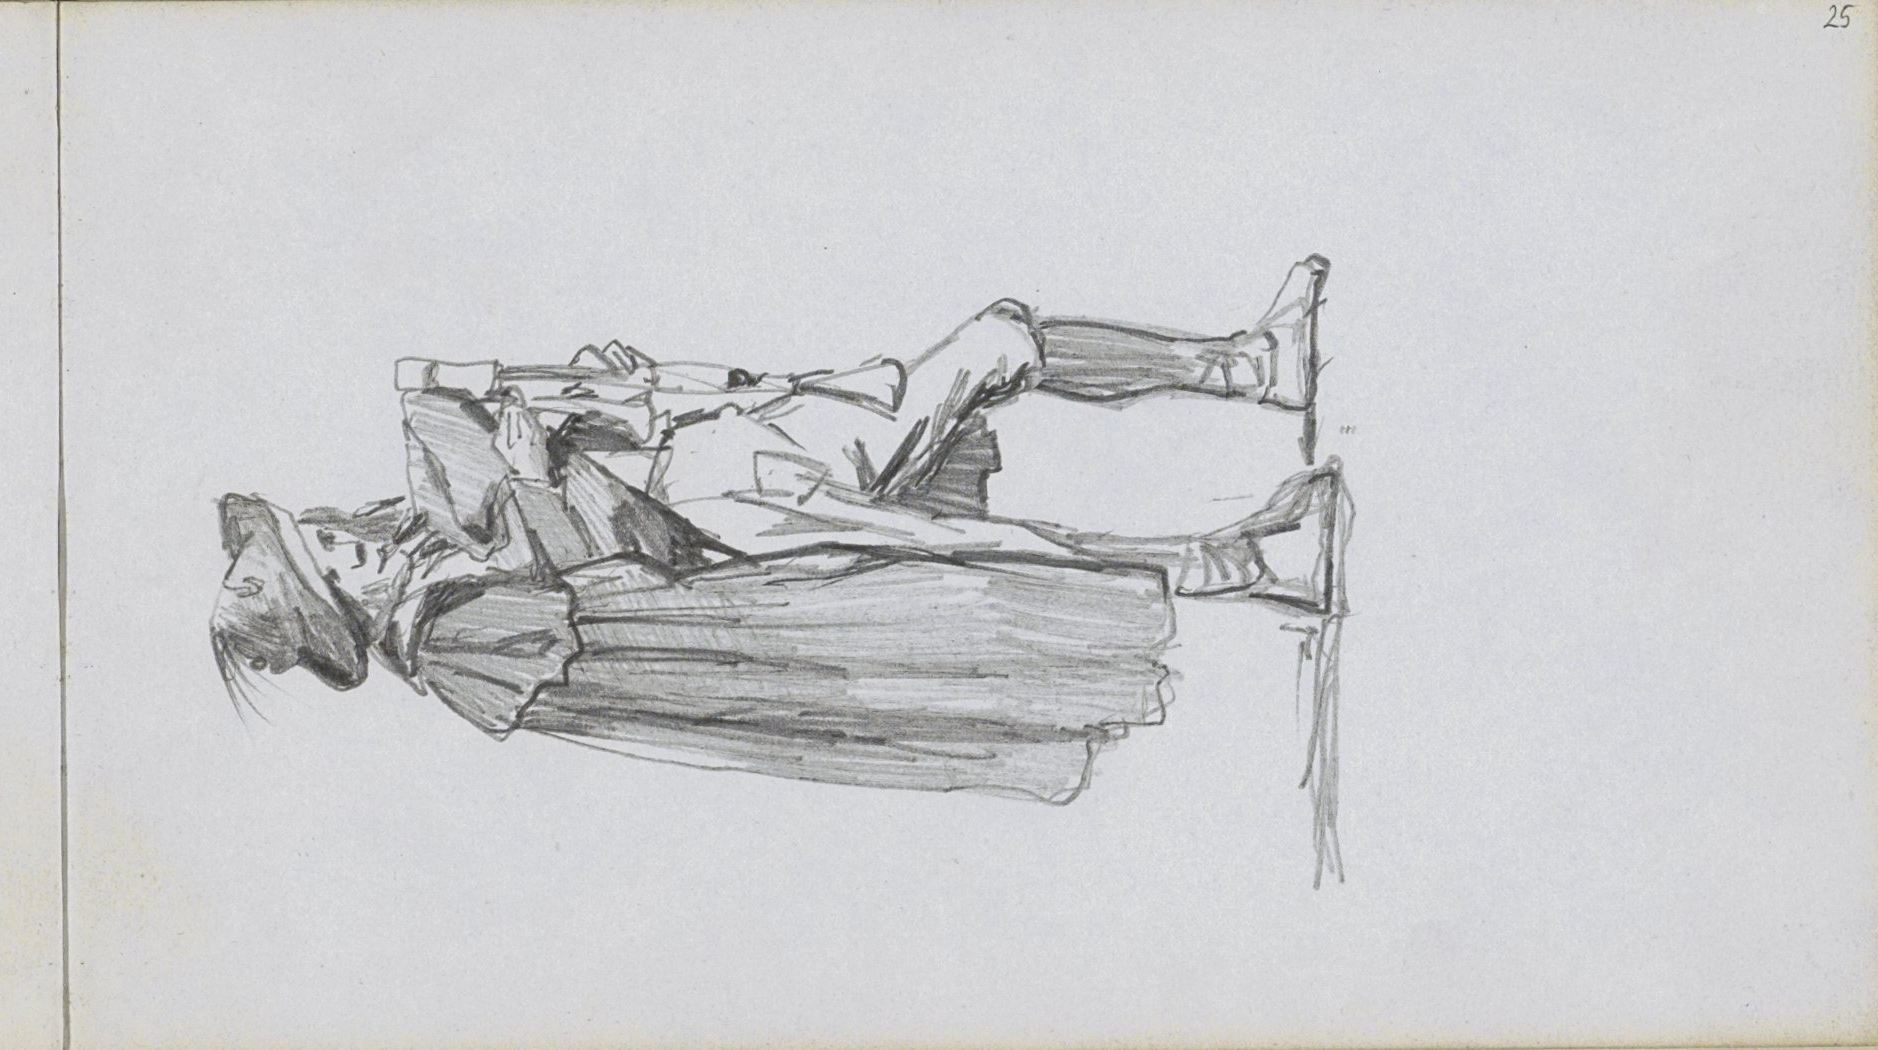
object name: sketchbook leaf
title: Doedelzakspeler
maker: johan hendrik weissenbruch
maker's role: draughtsman, painter, print maker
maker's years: 1824-1903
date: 1834-1903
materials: paper, pencil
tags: bagpipe, musette (+ artist at work), coat, cape (+ men's clothes)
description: De muzikant draagt een hoed met veer en een cape. Blad 25 recto uit een schetsboek met 39 bladen.